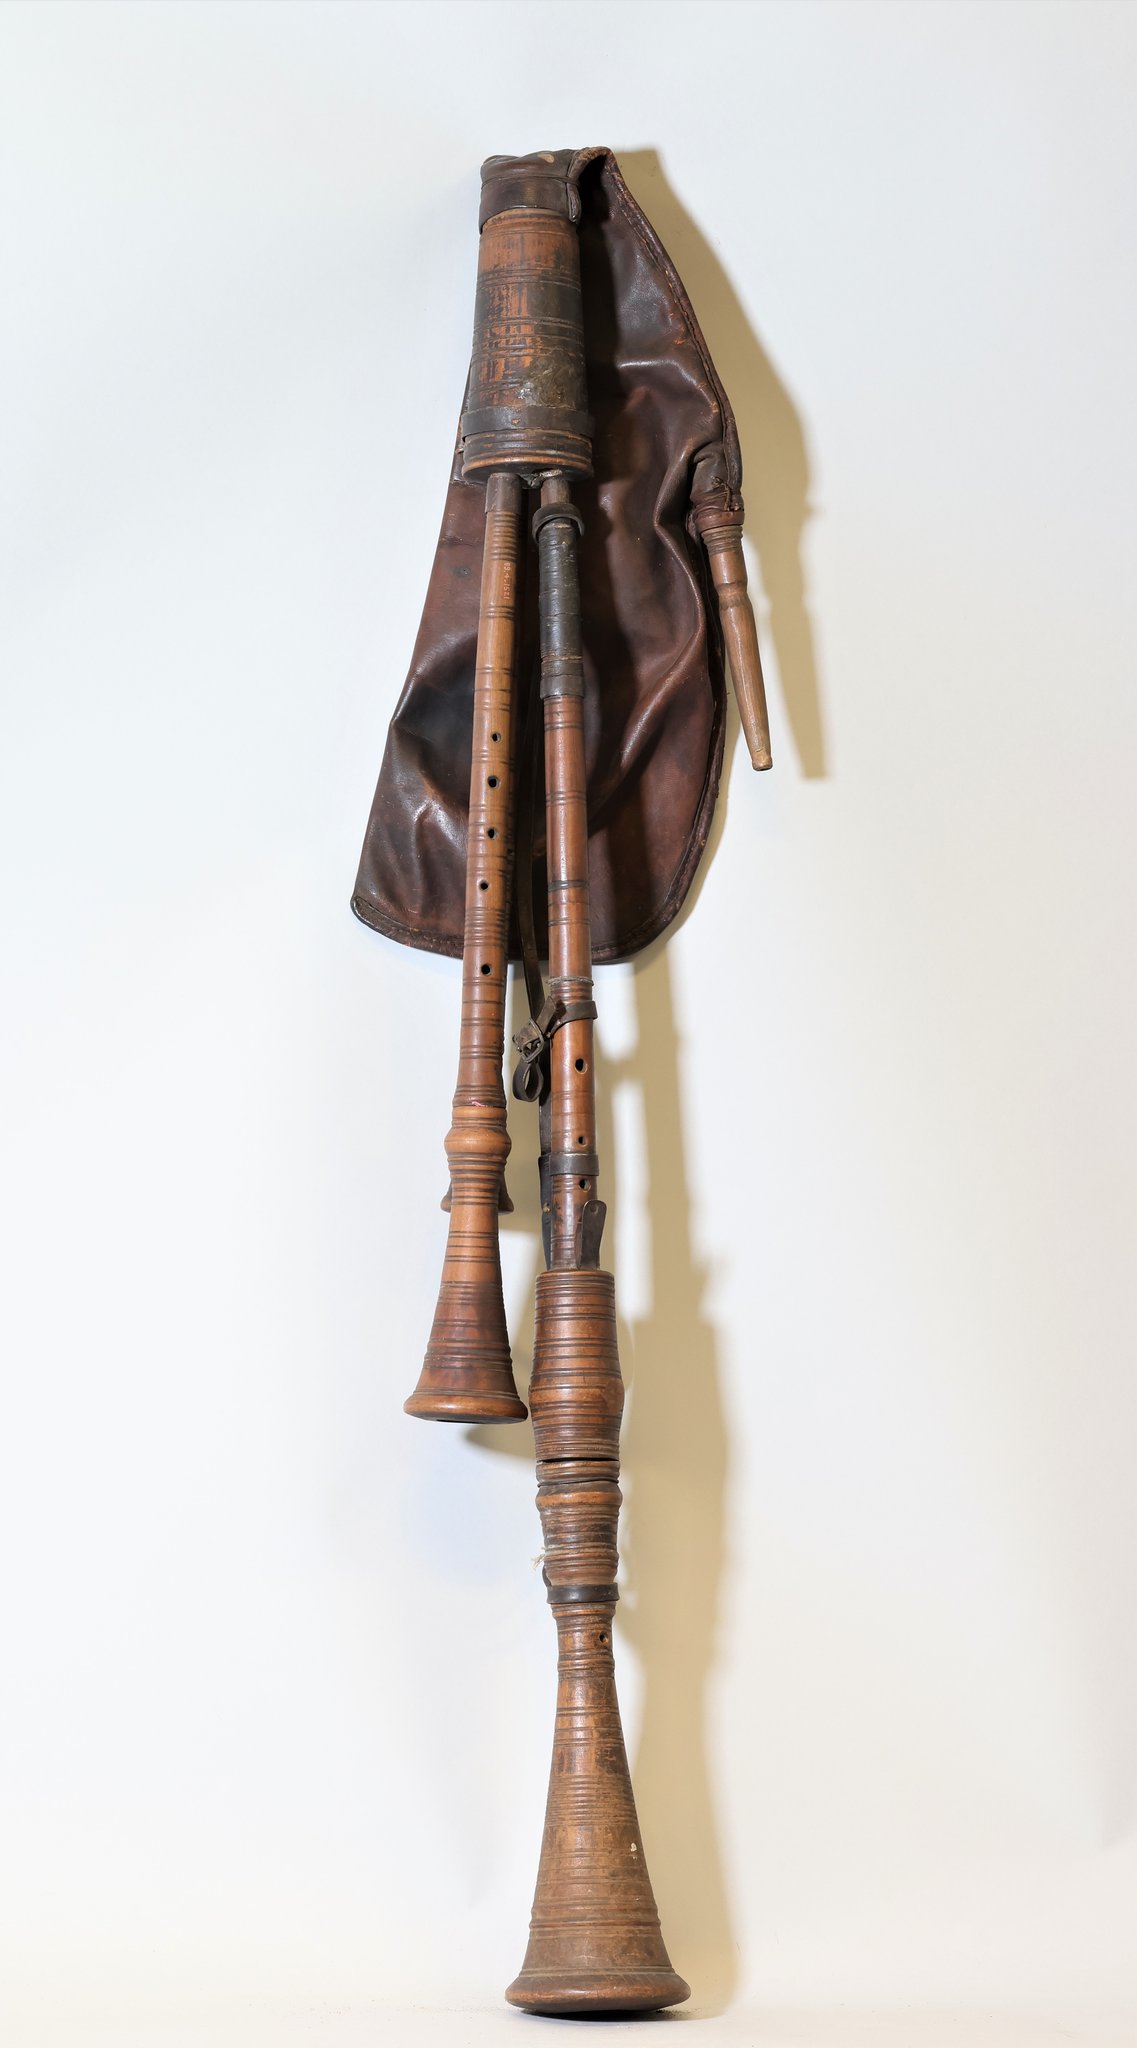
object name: zampogna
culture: italian or sicilian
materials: leather, metal, wood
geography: italy